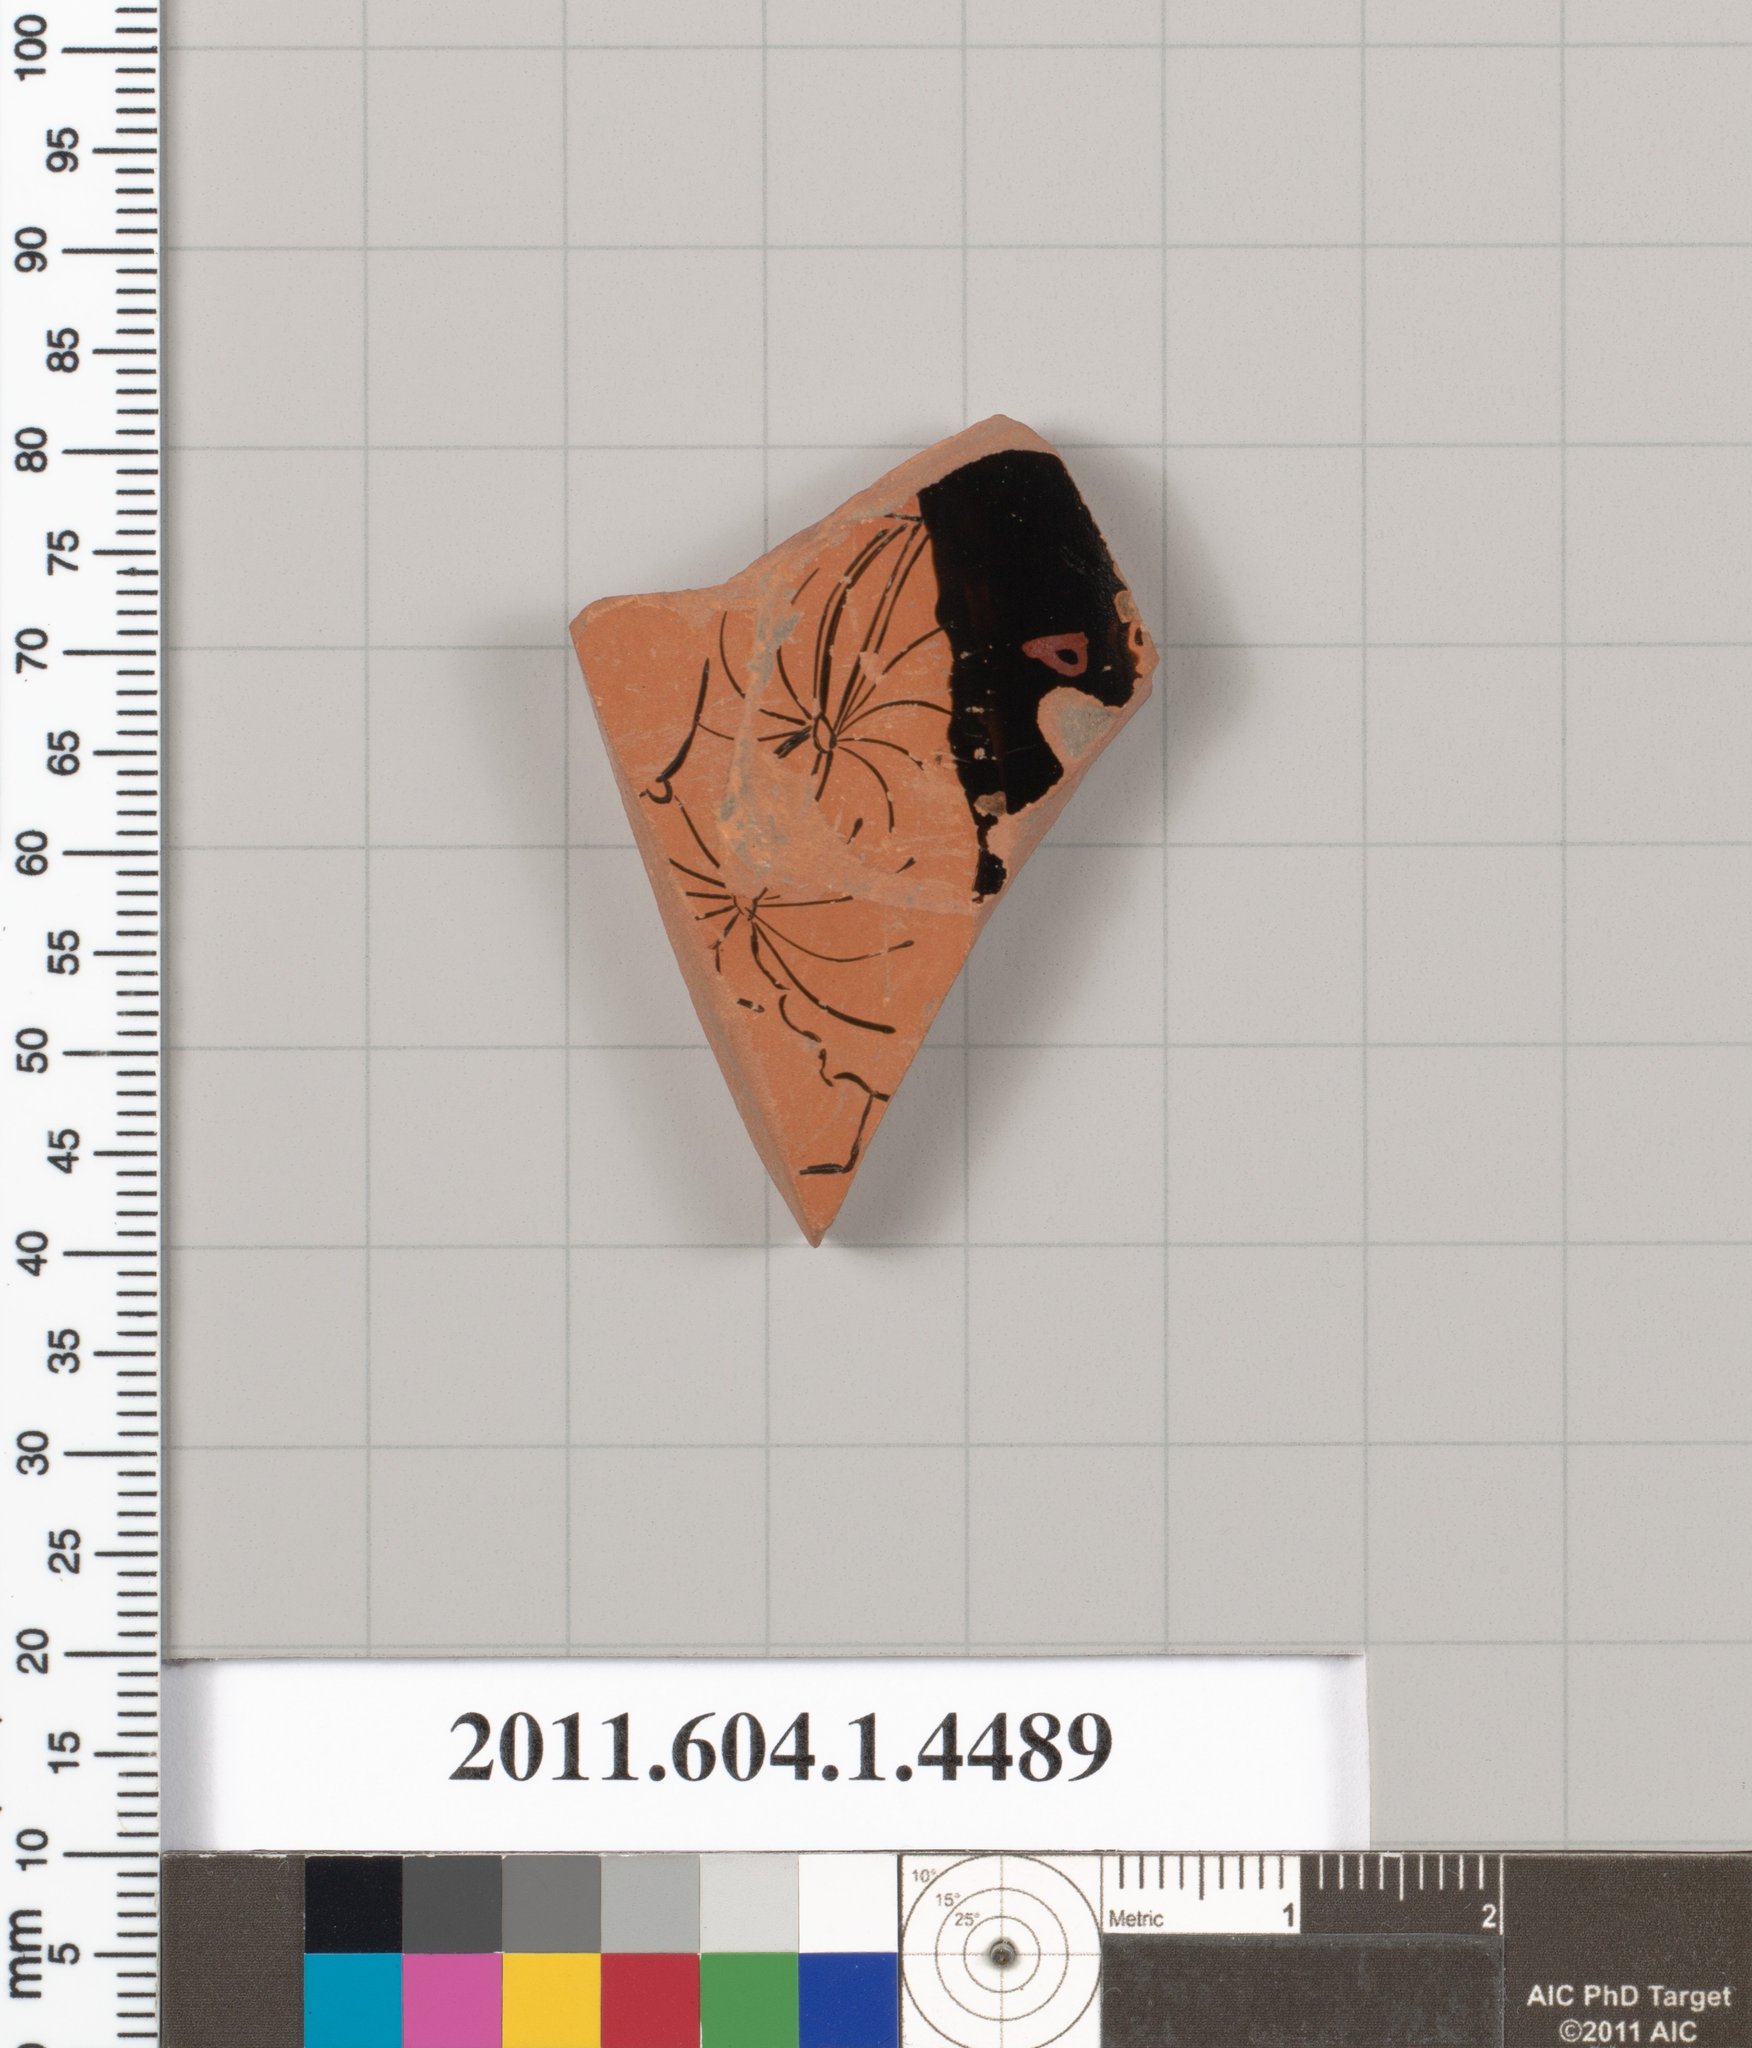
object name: kylix fragment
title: Terracotta fragment of a kylix (drinking cup)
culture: greek, attic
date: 500-480 BCE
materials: terracotta